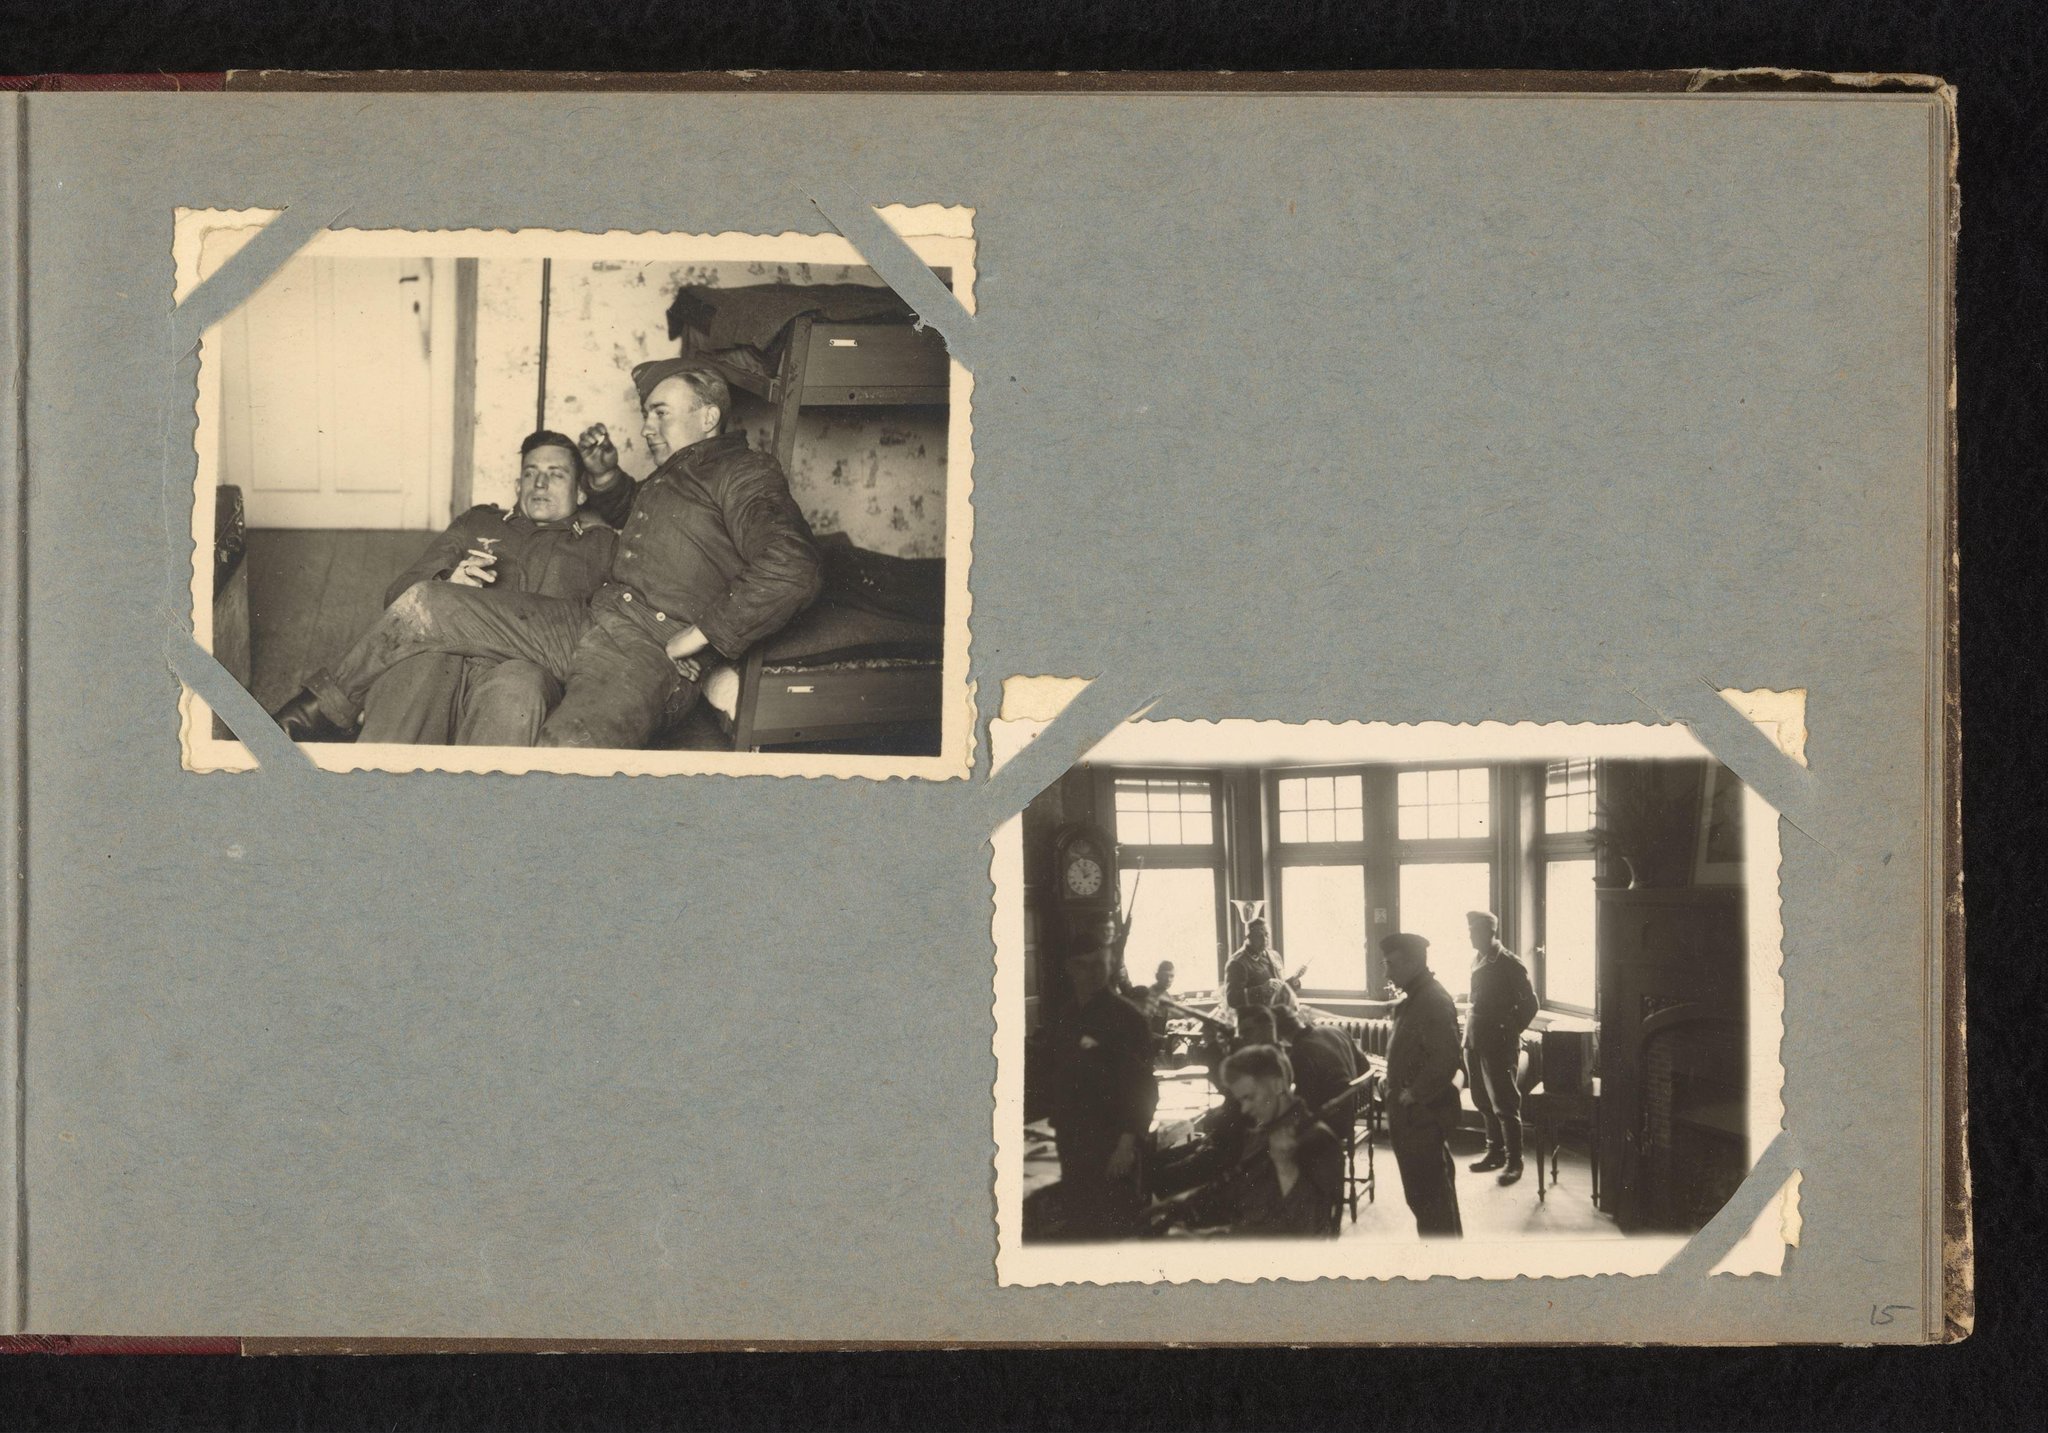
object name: album leaf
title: Duitse militairen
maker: Anonymous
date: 1940-1945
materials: paper, photographic support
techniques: gelatin silver print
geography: germany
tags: the company, the unit, the troop ~ military service, the soldier off duty, germany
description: Albumblad met twee foto's van Duitse militairen in vrije tijd. Onderdeel van een fotoalbum over de diensttijd van Dieter Glitsch uit Hardegsen tijdens de Tweede Wereldoorlog en de jaren daarna.